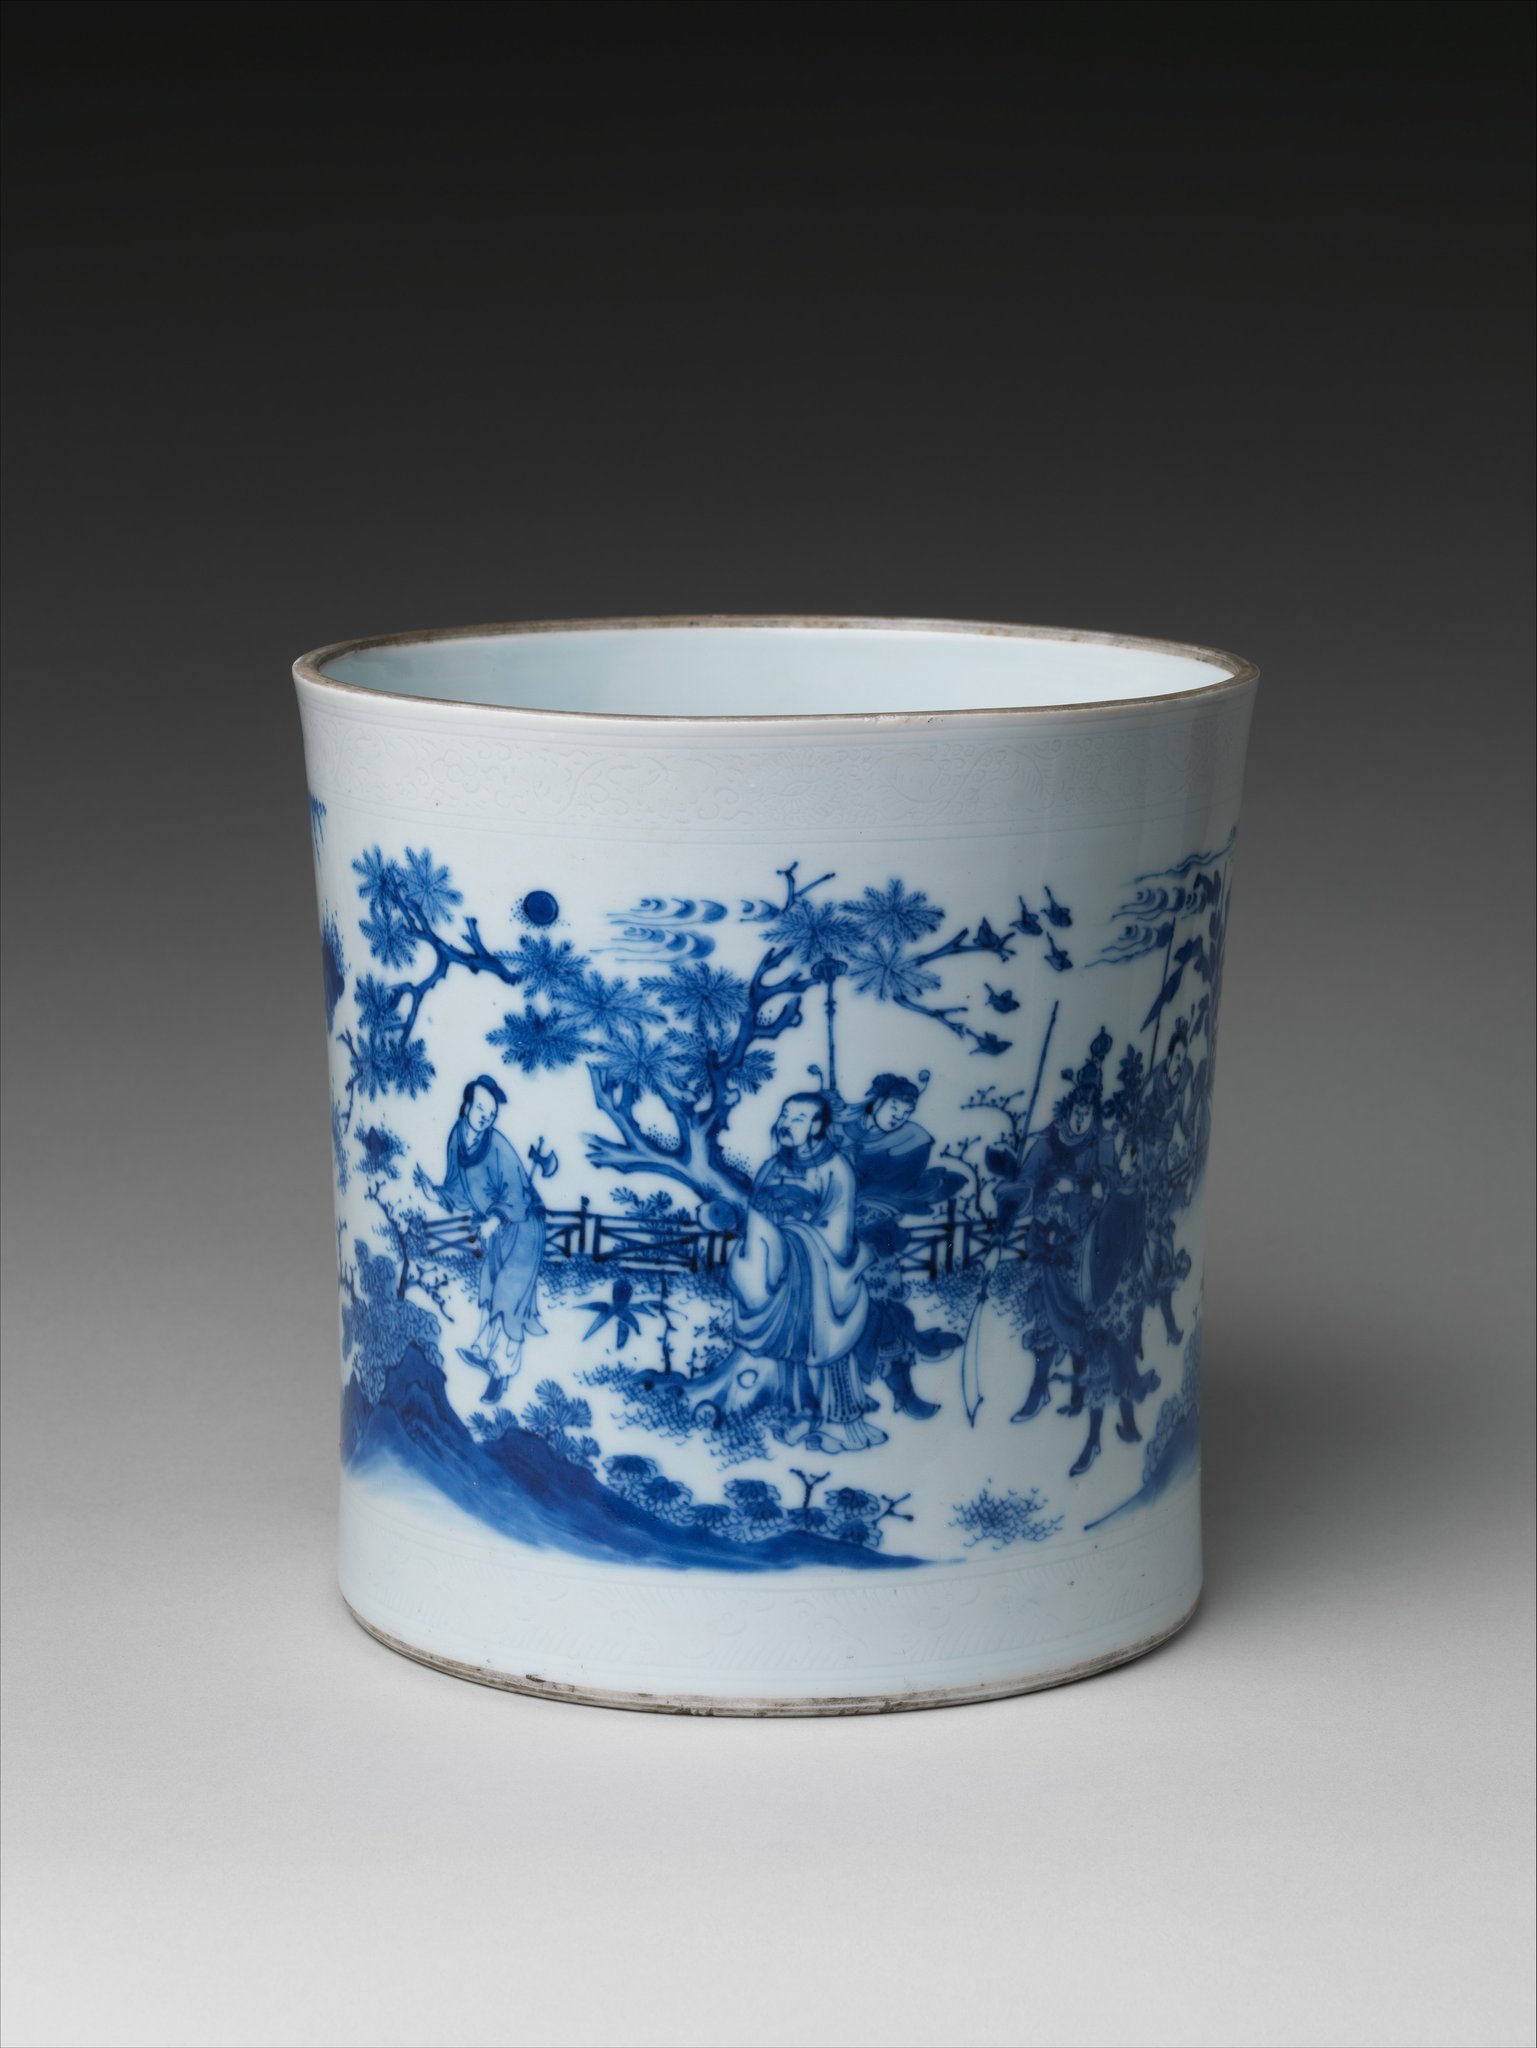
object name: brush holder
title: Brush Pot with King Wen and the Scholar Jiang Taigong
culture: chinese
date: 1634-1666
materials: cobalt, glaze, porcelain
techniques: incising, painting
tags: men,trees